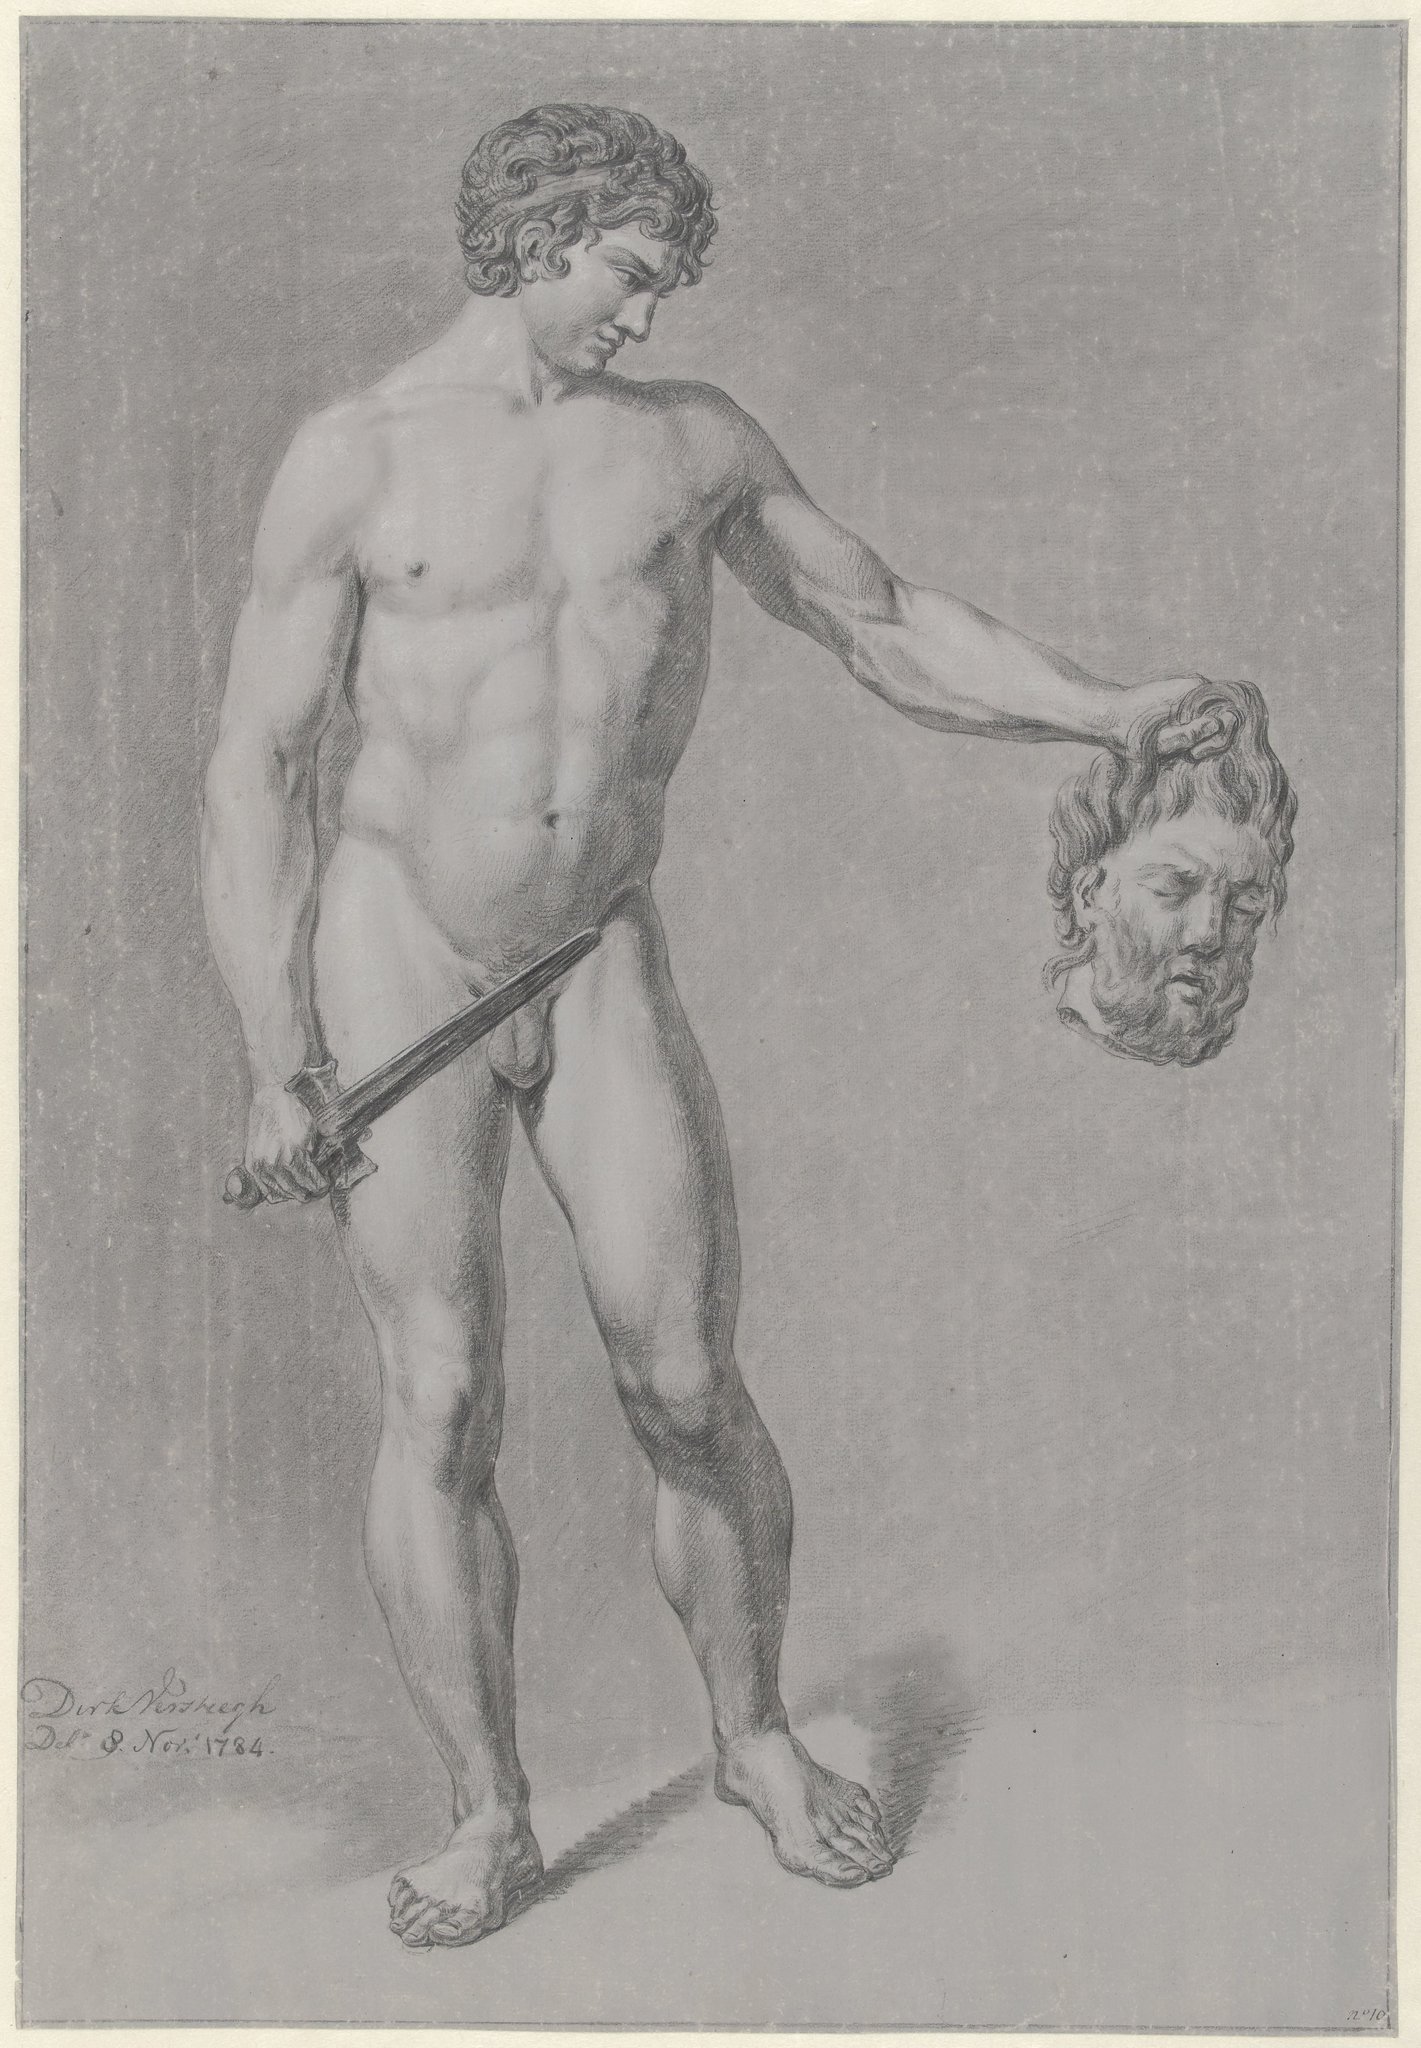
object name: drawing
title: Staand mannelijk naakt met een zwaard en een afgehouwen hoofd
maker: dirk versteegh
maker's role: draughtsman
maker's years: 1751-1822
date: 1784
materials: chalk, pencil, paper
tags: standing figure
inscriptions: date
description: Staand mannelijk naakt met een zwaard en een afgehouwen hoofd. Linksonder: No. 10.